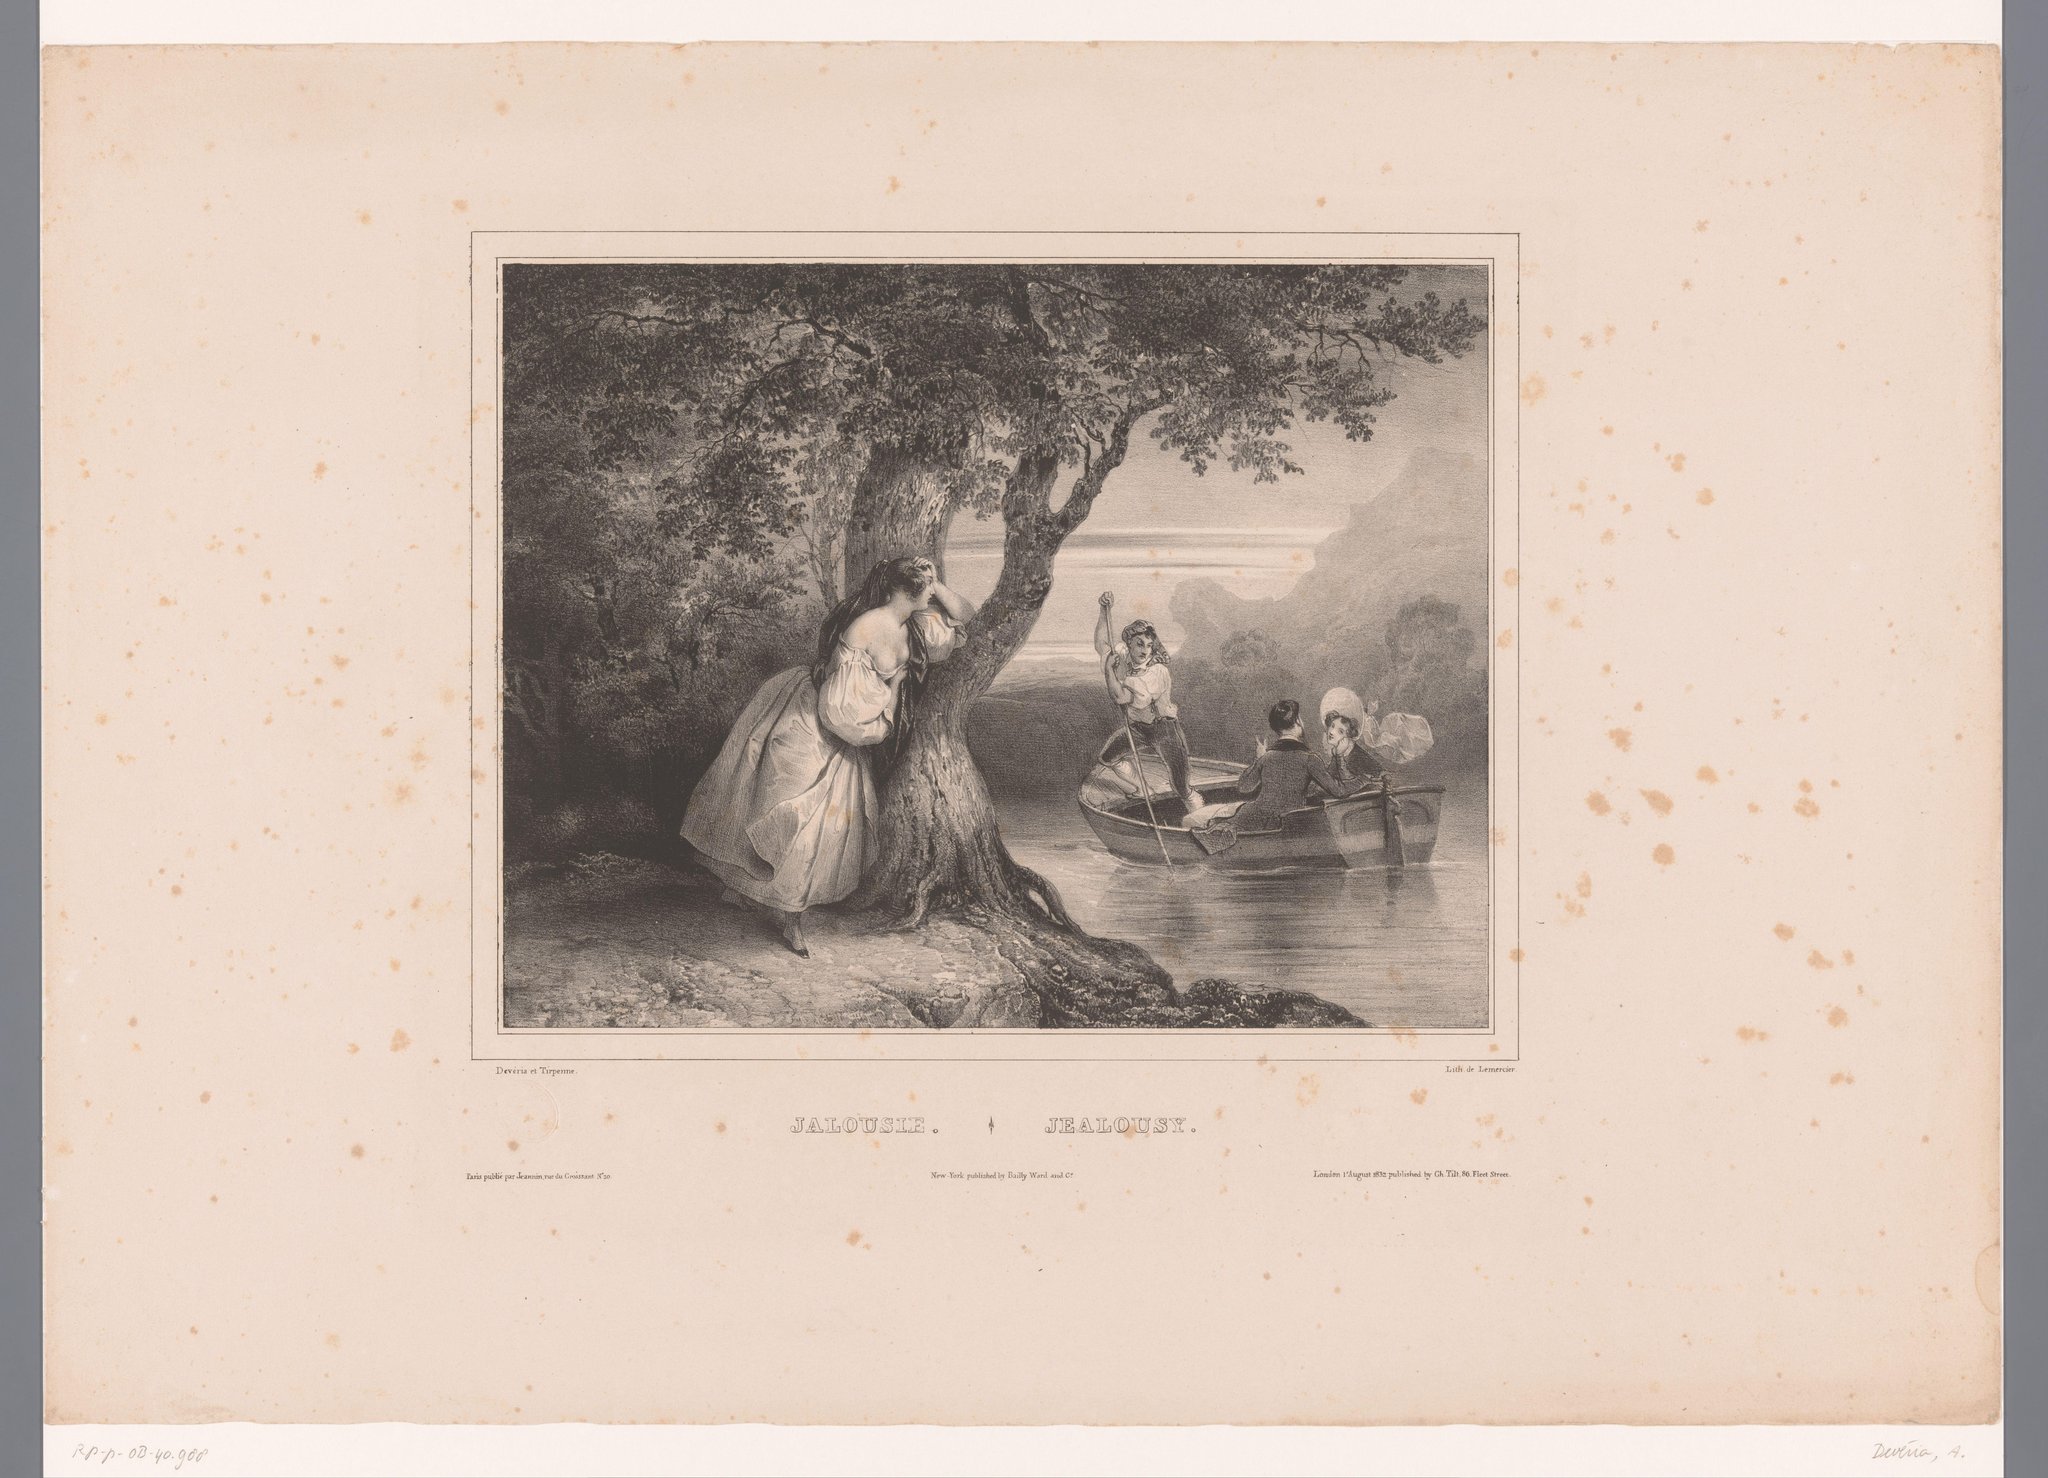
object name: print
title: Jalousie / Jealousy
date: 1832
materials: paper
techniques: lithograph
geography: london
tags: rowing-boat, canoe, etc., jealousy; 'gelosia', 'rammarico del ben'altrui' (ripa), couple of lovers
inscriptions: check stamp: Lugt 3987